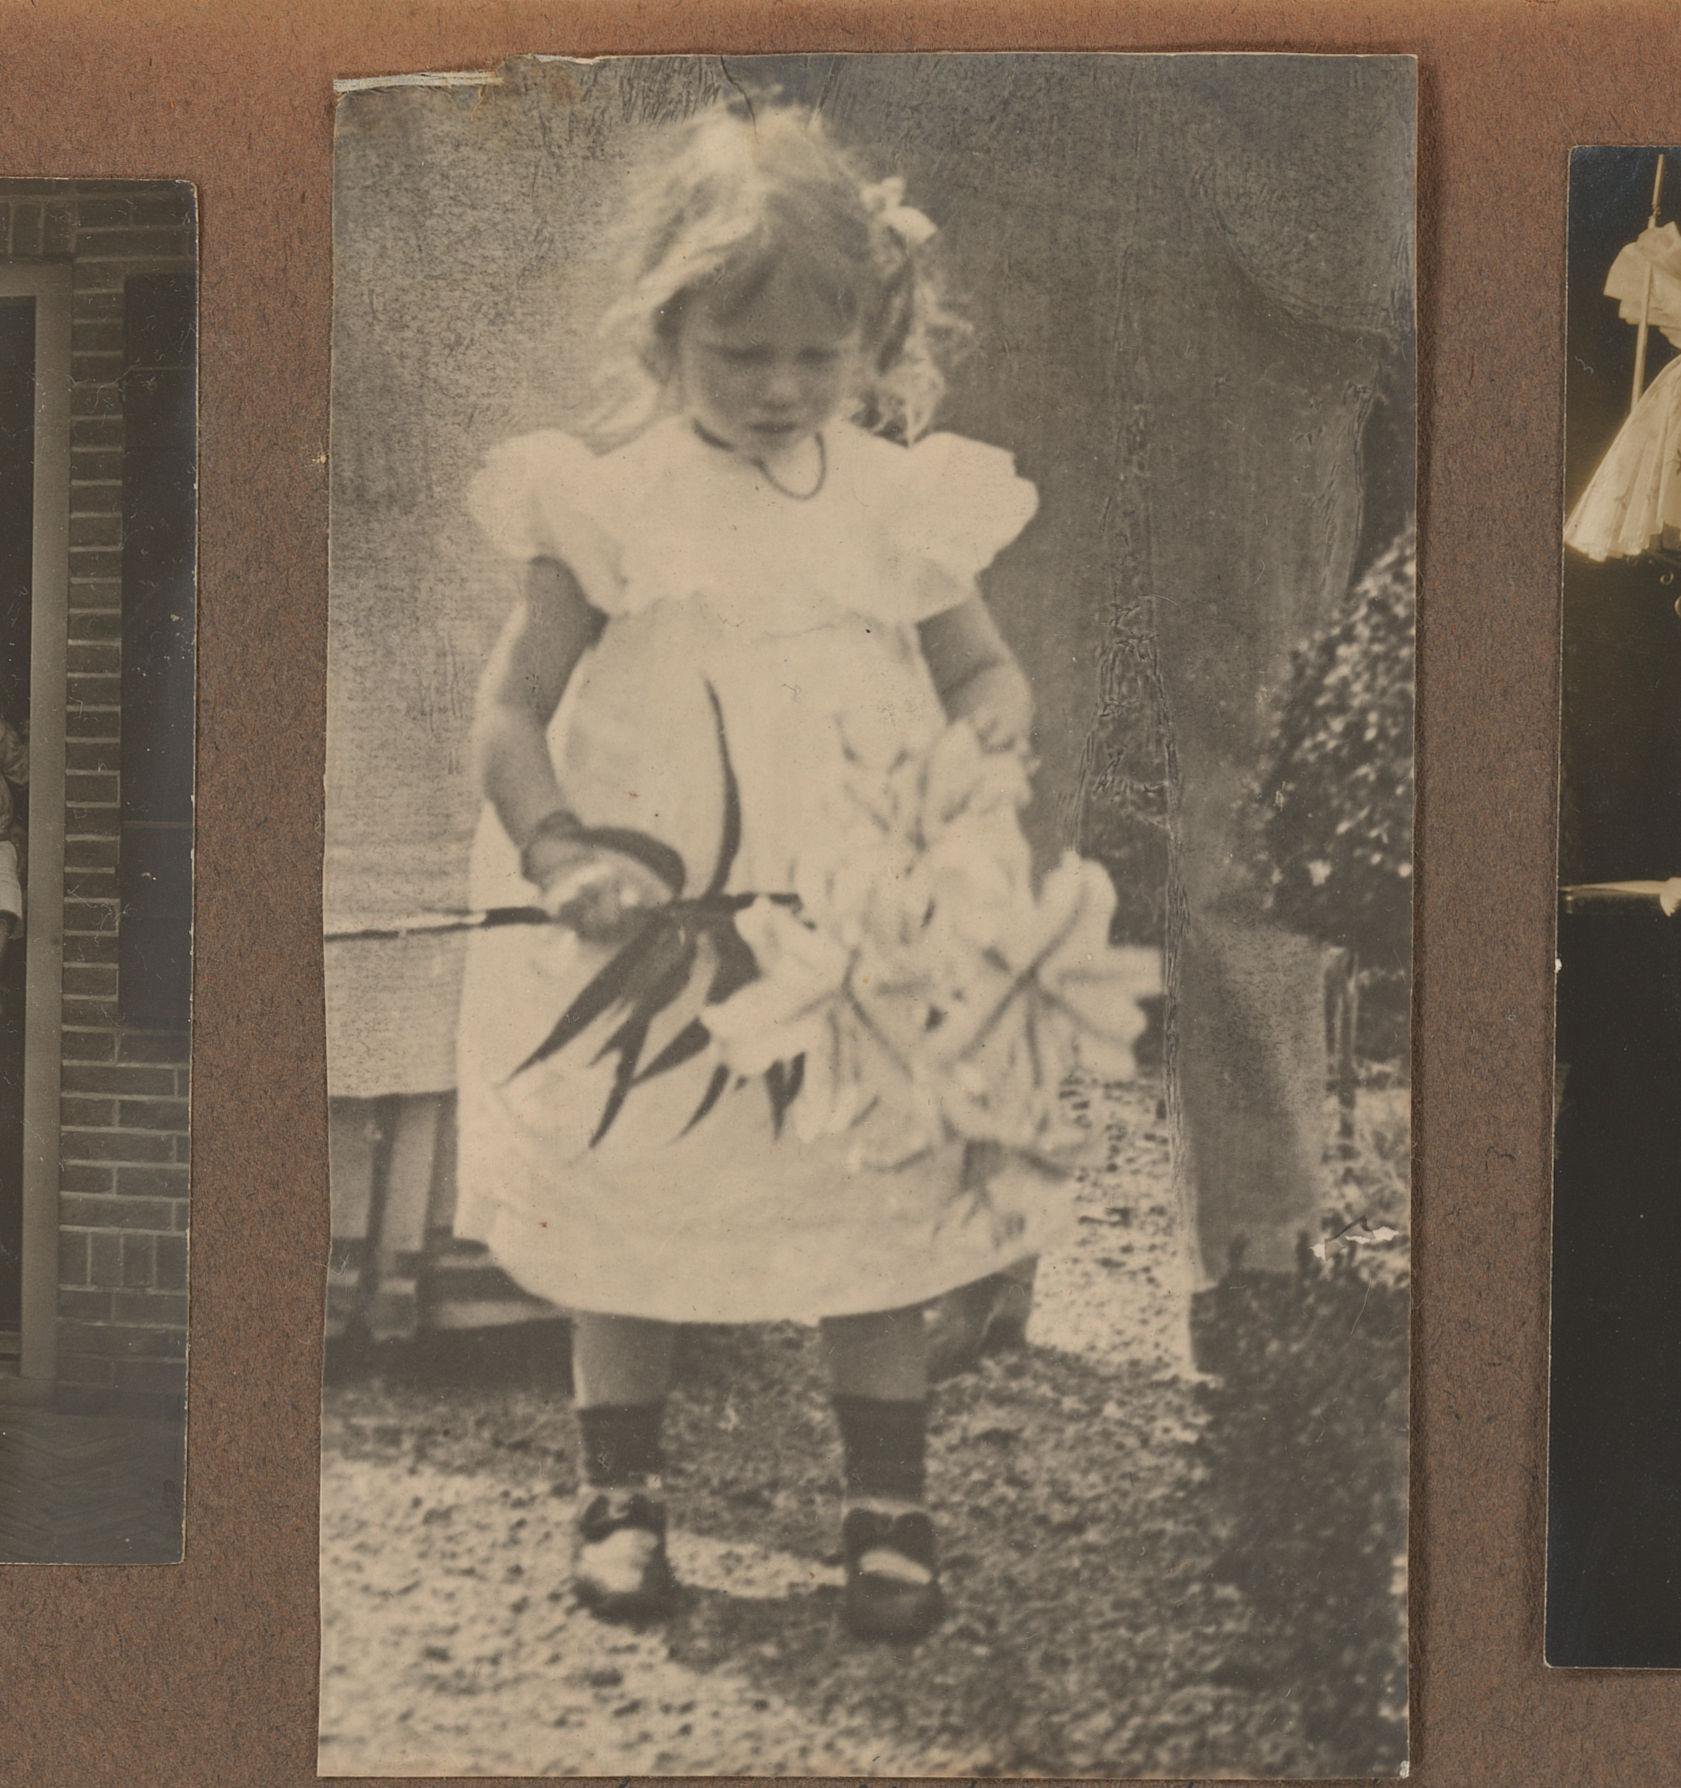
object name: photograph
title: Joanna Diepenbrock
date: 1908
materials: photographic support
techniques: photography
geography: amsterdam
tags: netherlands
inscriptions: inscription: ‘... 3e verjaardag.’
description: Foto op bruin albumblad 28 van familiealbum van Alphons Diepenbrock.